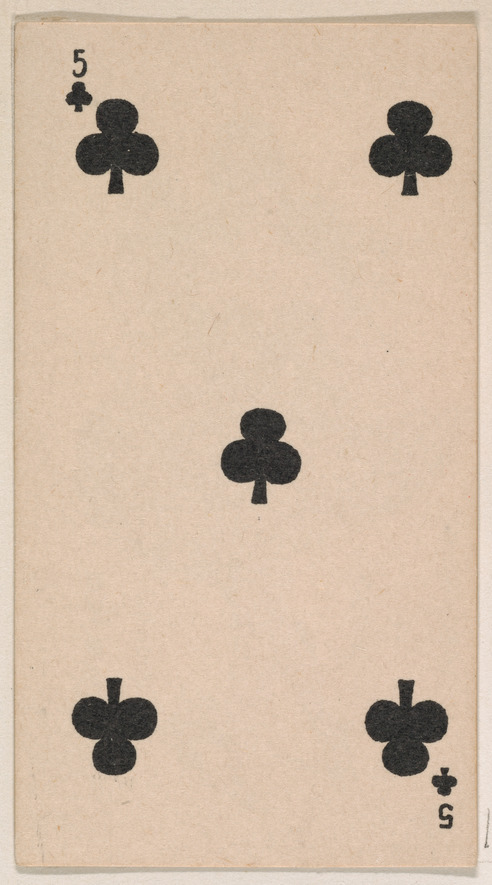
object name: print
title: Five of Clubs, from the Transparent Playing Cards series (N220) issued by Kinney Bros.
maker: kinney brothers tobacco company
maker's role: publisher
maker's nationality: american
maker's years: 1869-2011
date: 1888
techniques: color lithograph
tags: playing cards